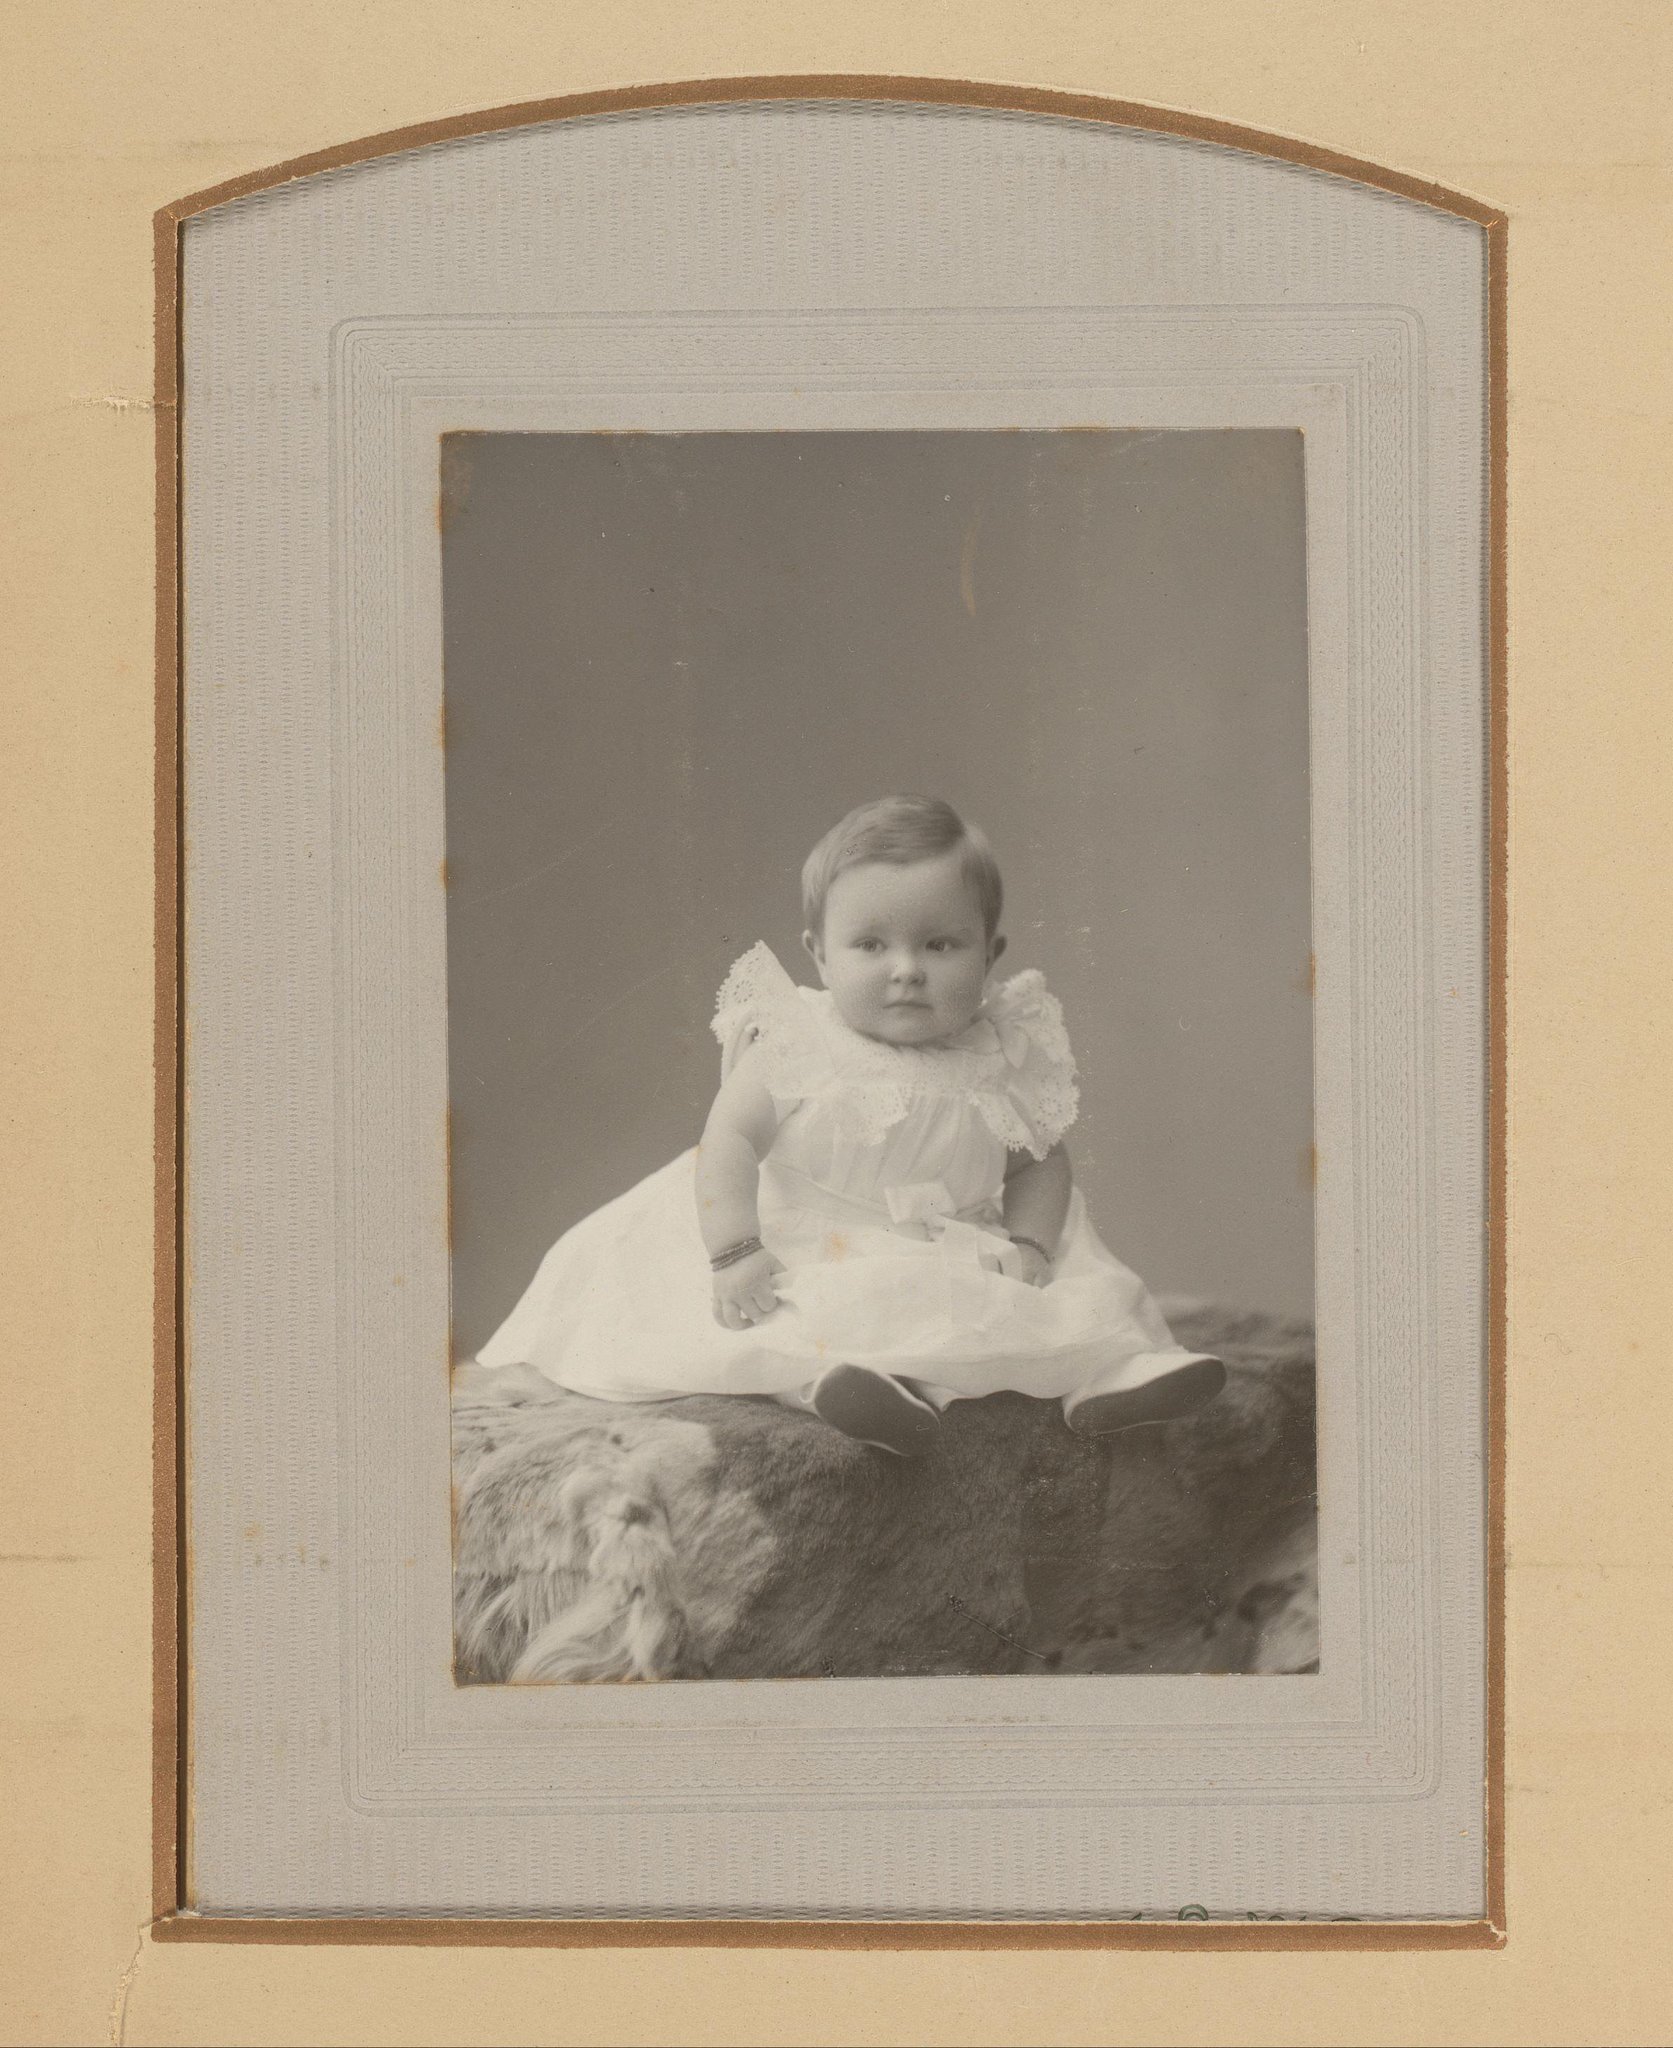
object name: photograph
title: Portret van een zittende baby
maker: guillame maximilien zimmermann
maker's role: fotograaf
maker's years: 1873-1951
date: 1897-1902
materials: cardboard, photographic support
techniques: matte daylight collodion silver print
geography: amsterdam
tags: sitting figure, historical persons, infant, baby ~ the ages of man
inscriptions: inscription: ‘Willy Zimmermann/ Const. huijg. straat 49/ Amsterdam.’